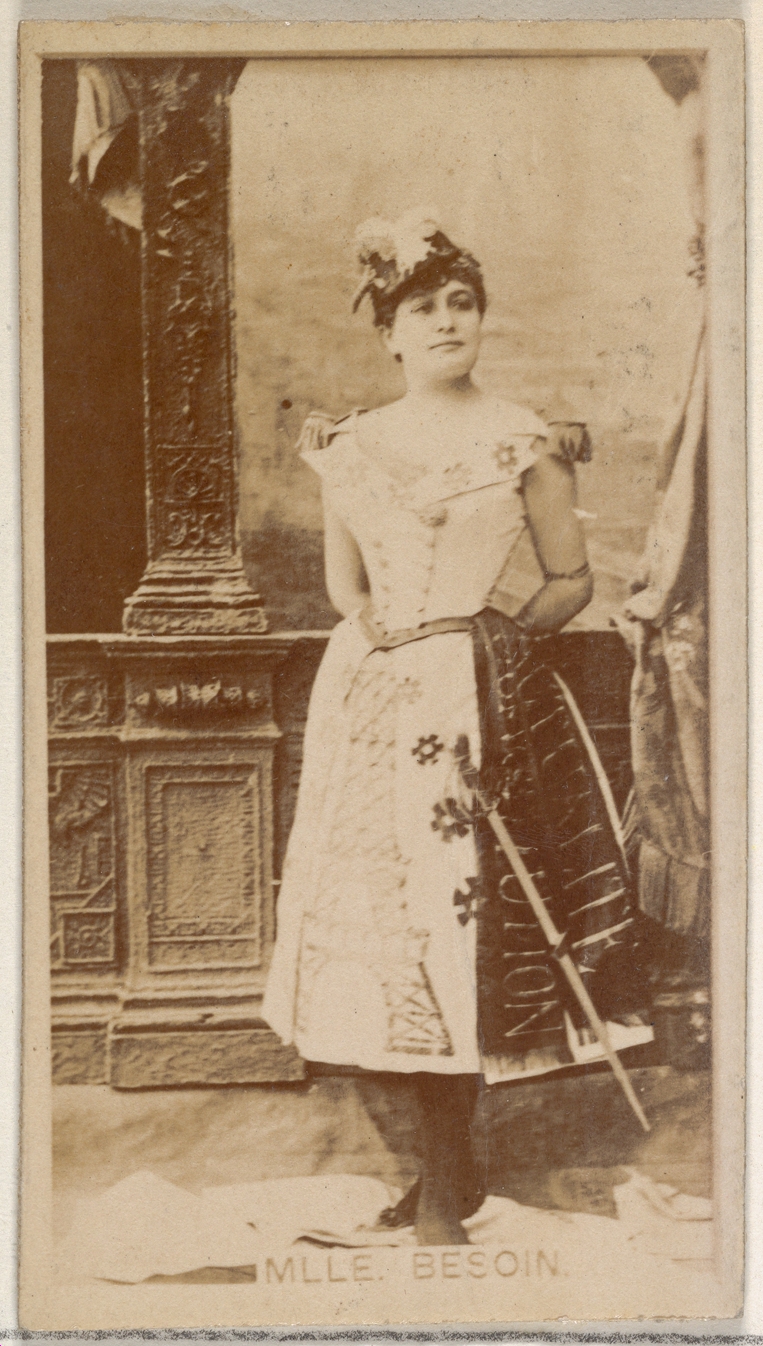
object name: photograph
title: Mlle. Besoin, from the Actors and Actresses series (N45, Type 8) for Virginia Brights Cigarettes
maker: allen & ginter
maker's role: publisher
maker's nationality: american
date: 1888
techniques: albumen silver print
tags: swords,portraits,women,actresses